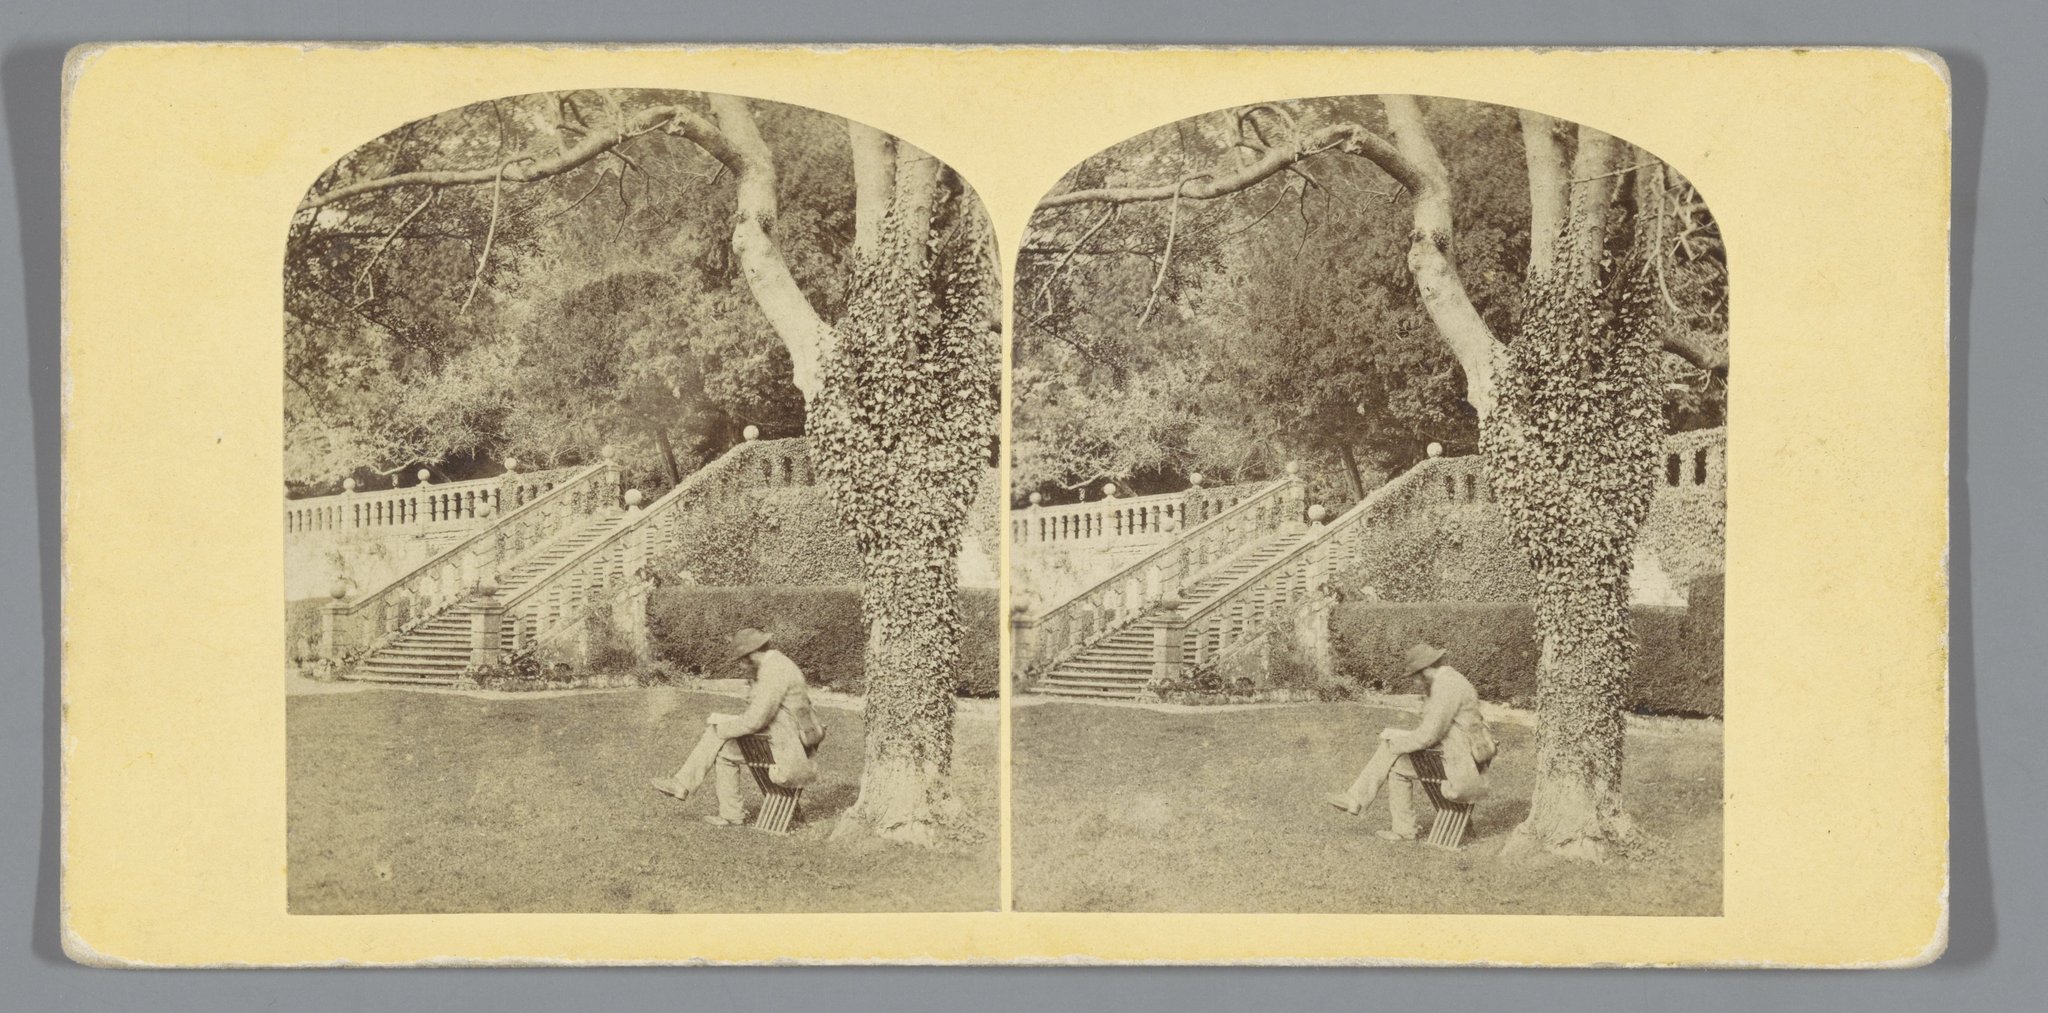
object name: stereograph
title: Man leest boek onder een boom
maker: william morris grundy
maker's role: fotograaf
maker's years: 1806-1859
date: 1857-1859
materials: cardboard, paper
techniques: albumen print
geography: birmingham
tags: reading